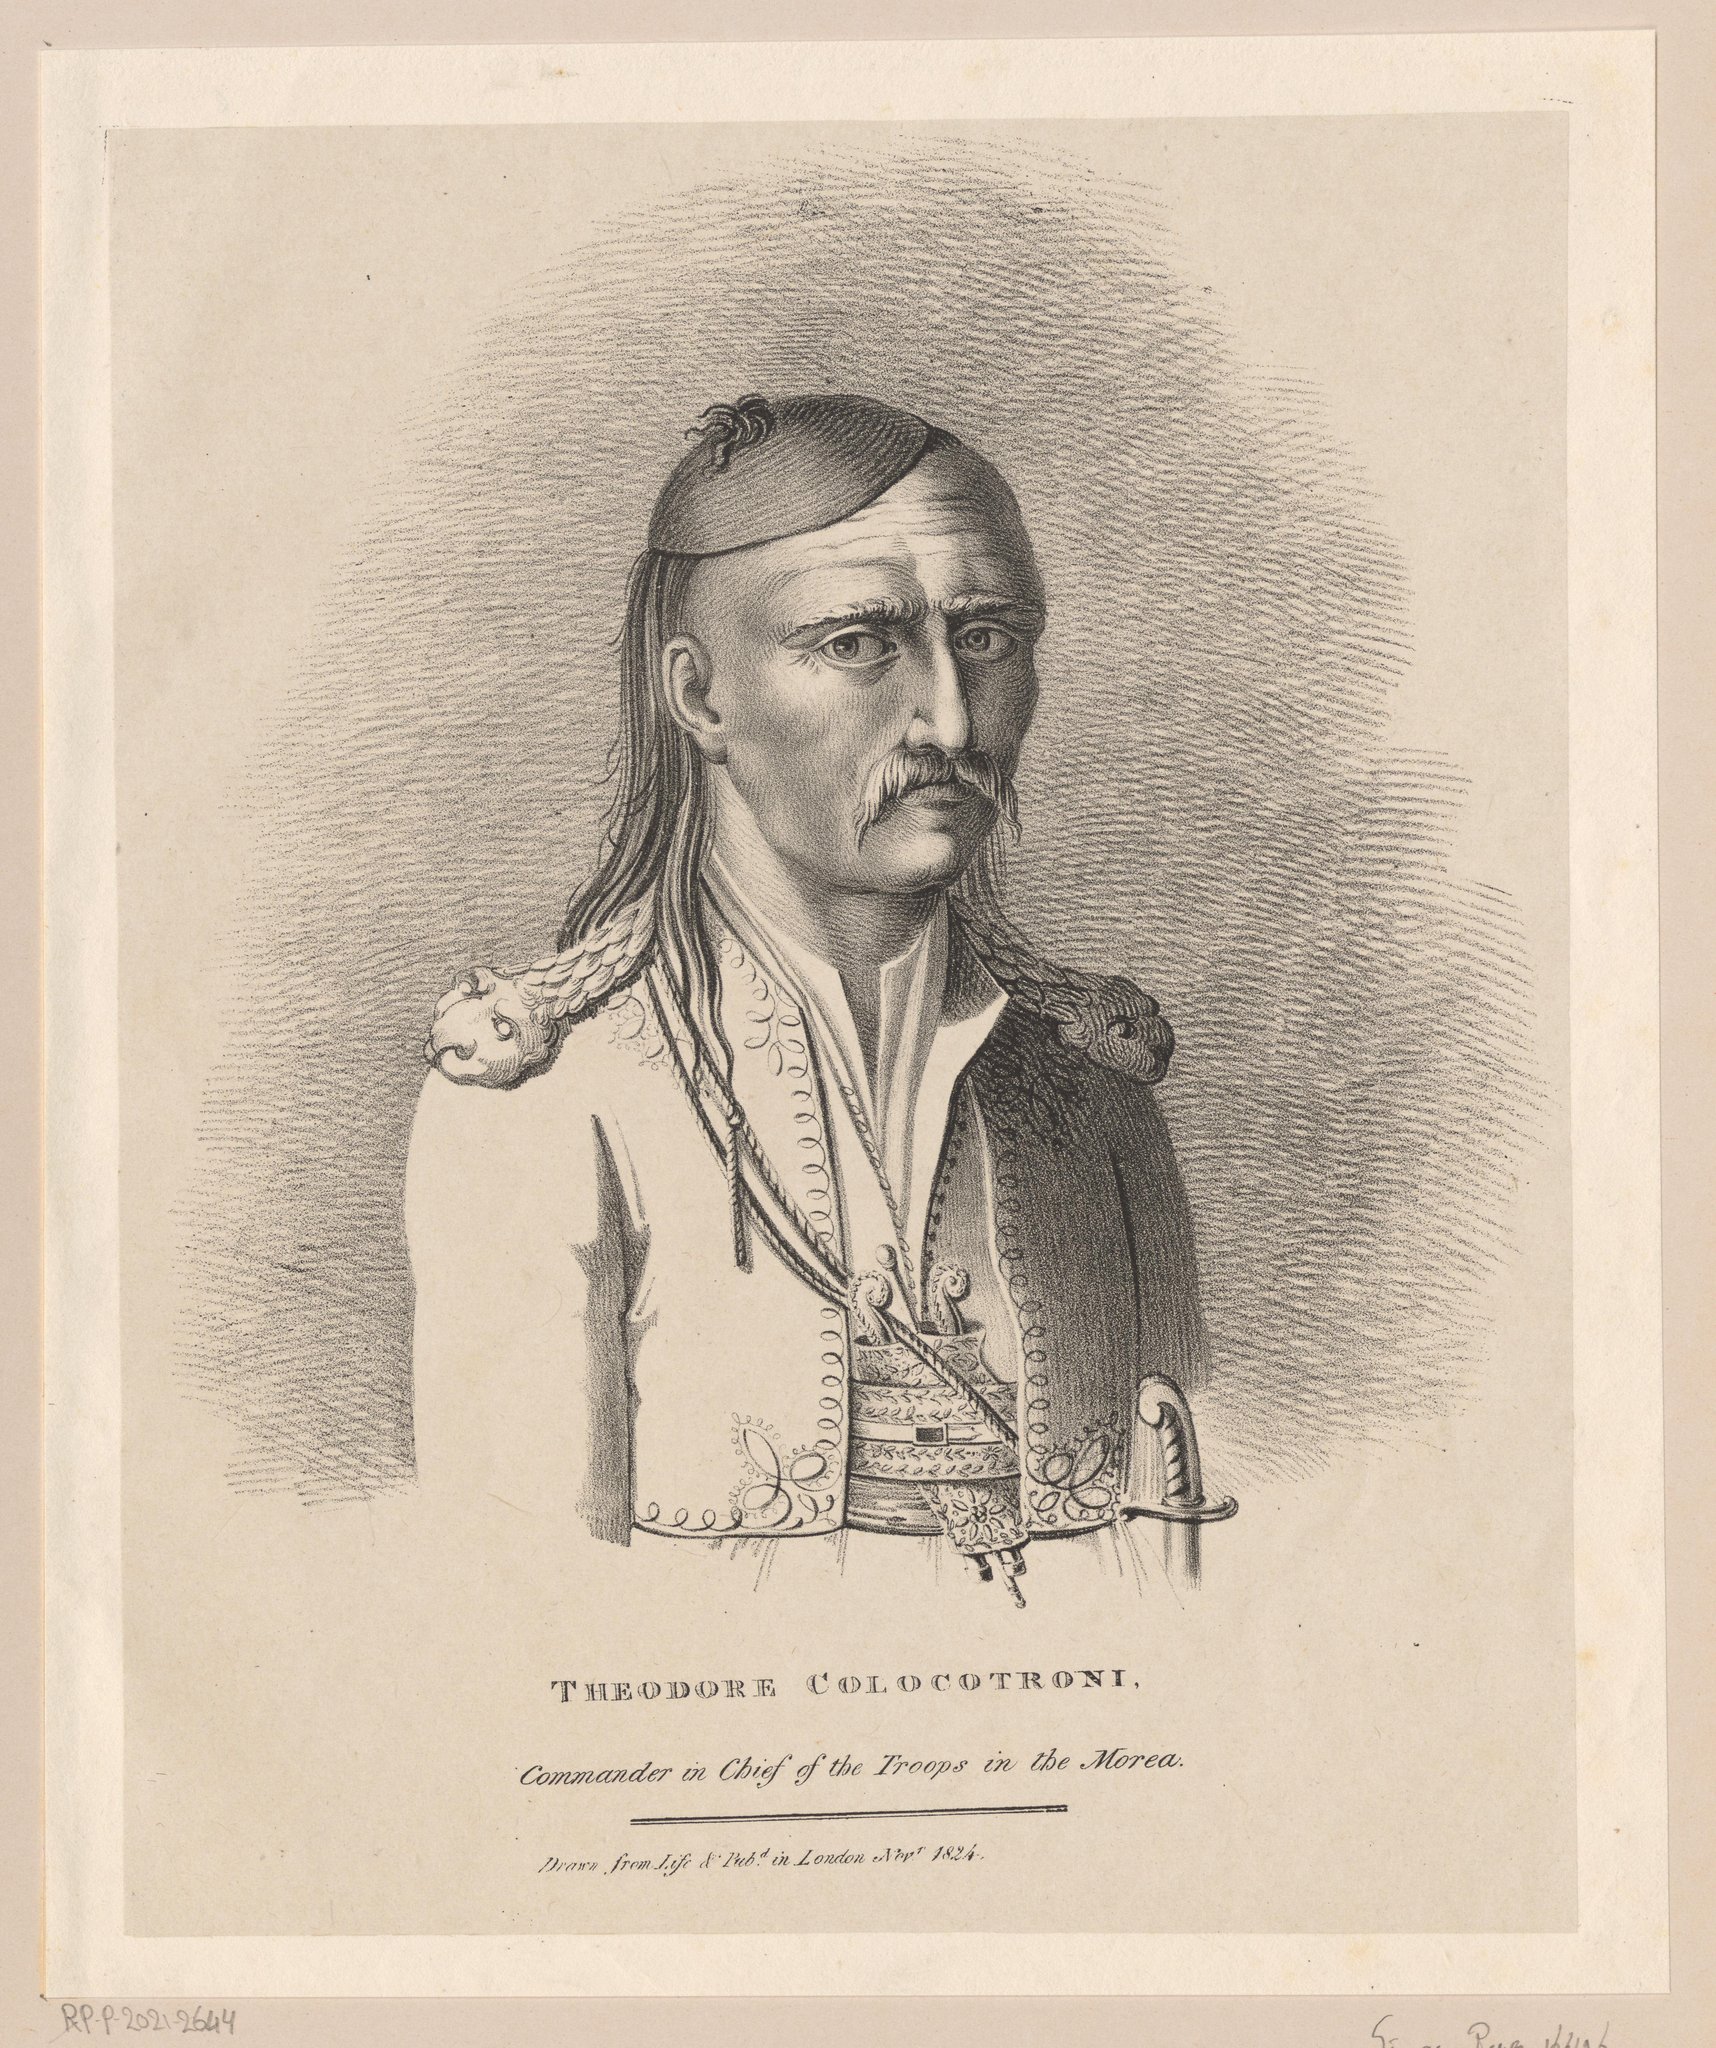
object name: print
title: Portret van Theodoros Kolokotronis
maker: Anonymous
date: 1811-1824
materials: paper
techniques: lithograph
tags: historical persons, hacking and thrusting weapons: sword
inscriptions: date